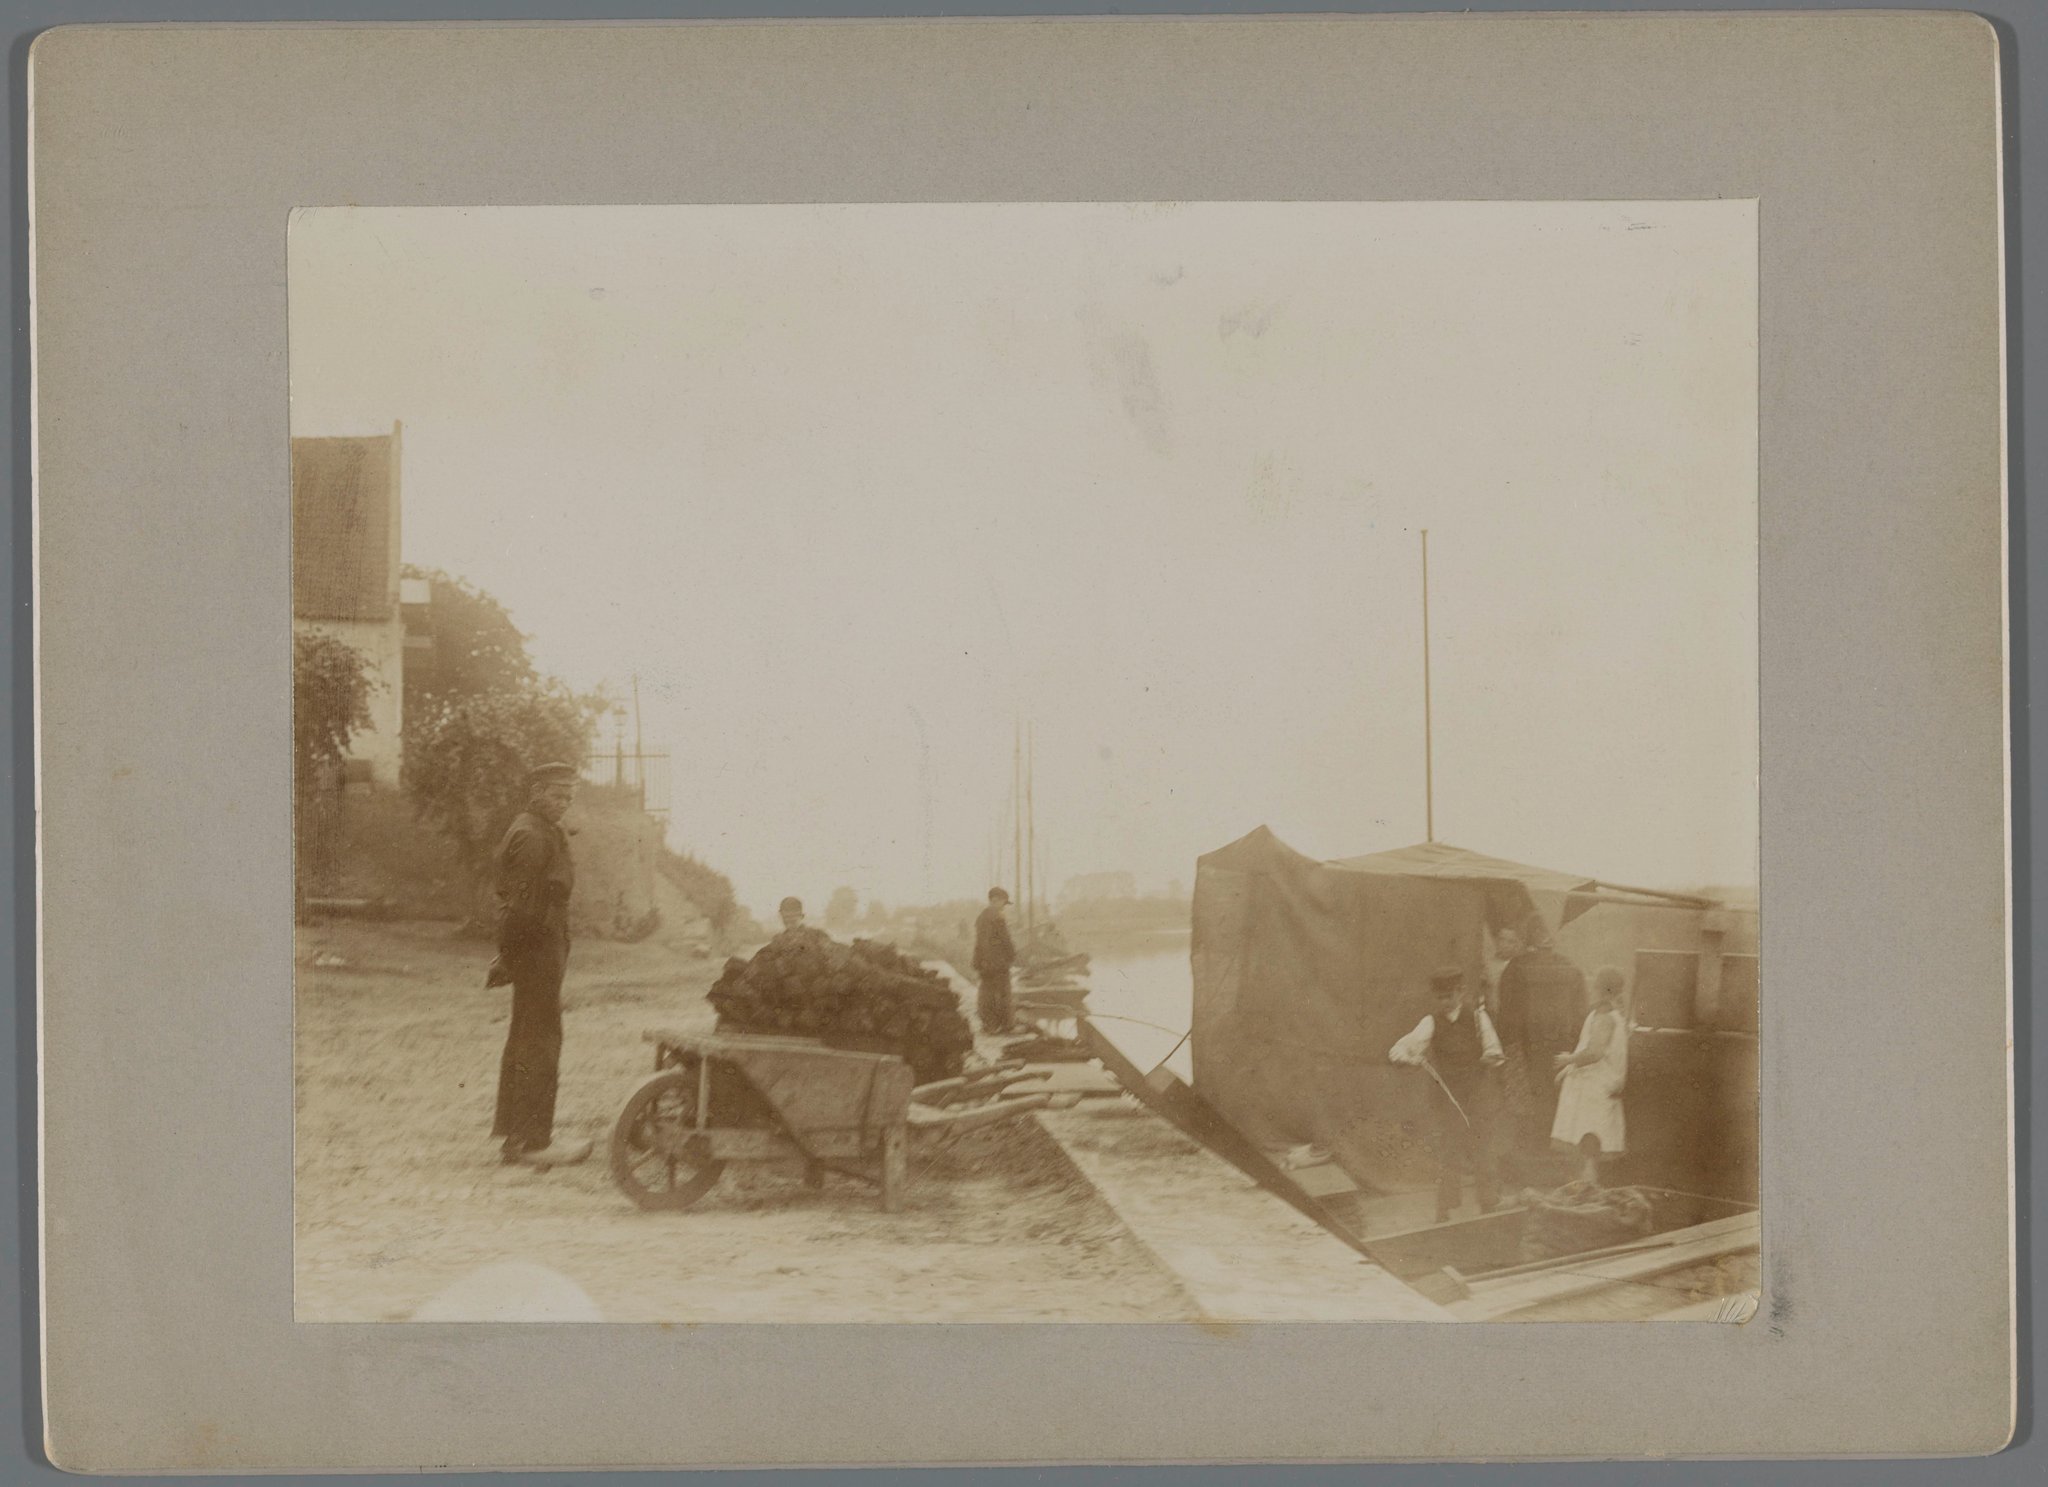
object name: photograph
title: Aan de kade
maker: cornelia hendrika jonker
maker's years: 1874-1924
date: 1880-1940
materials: cardboard, photographic support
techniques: collodion silver print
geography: hattem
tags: historical persons, quay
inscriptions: annotation: ‘Hattem?/ C’